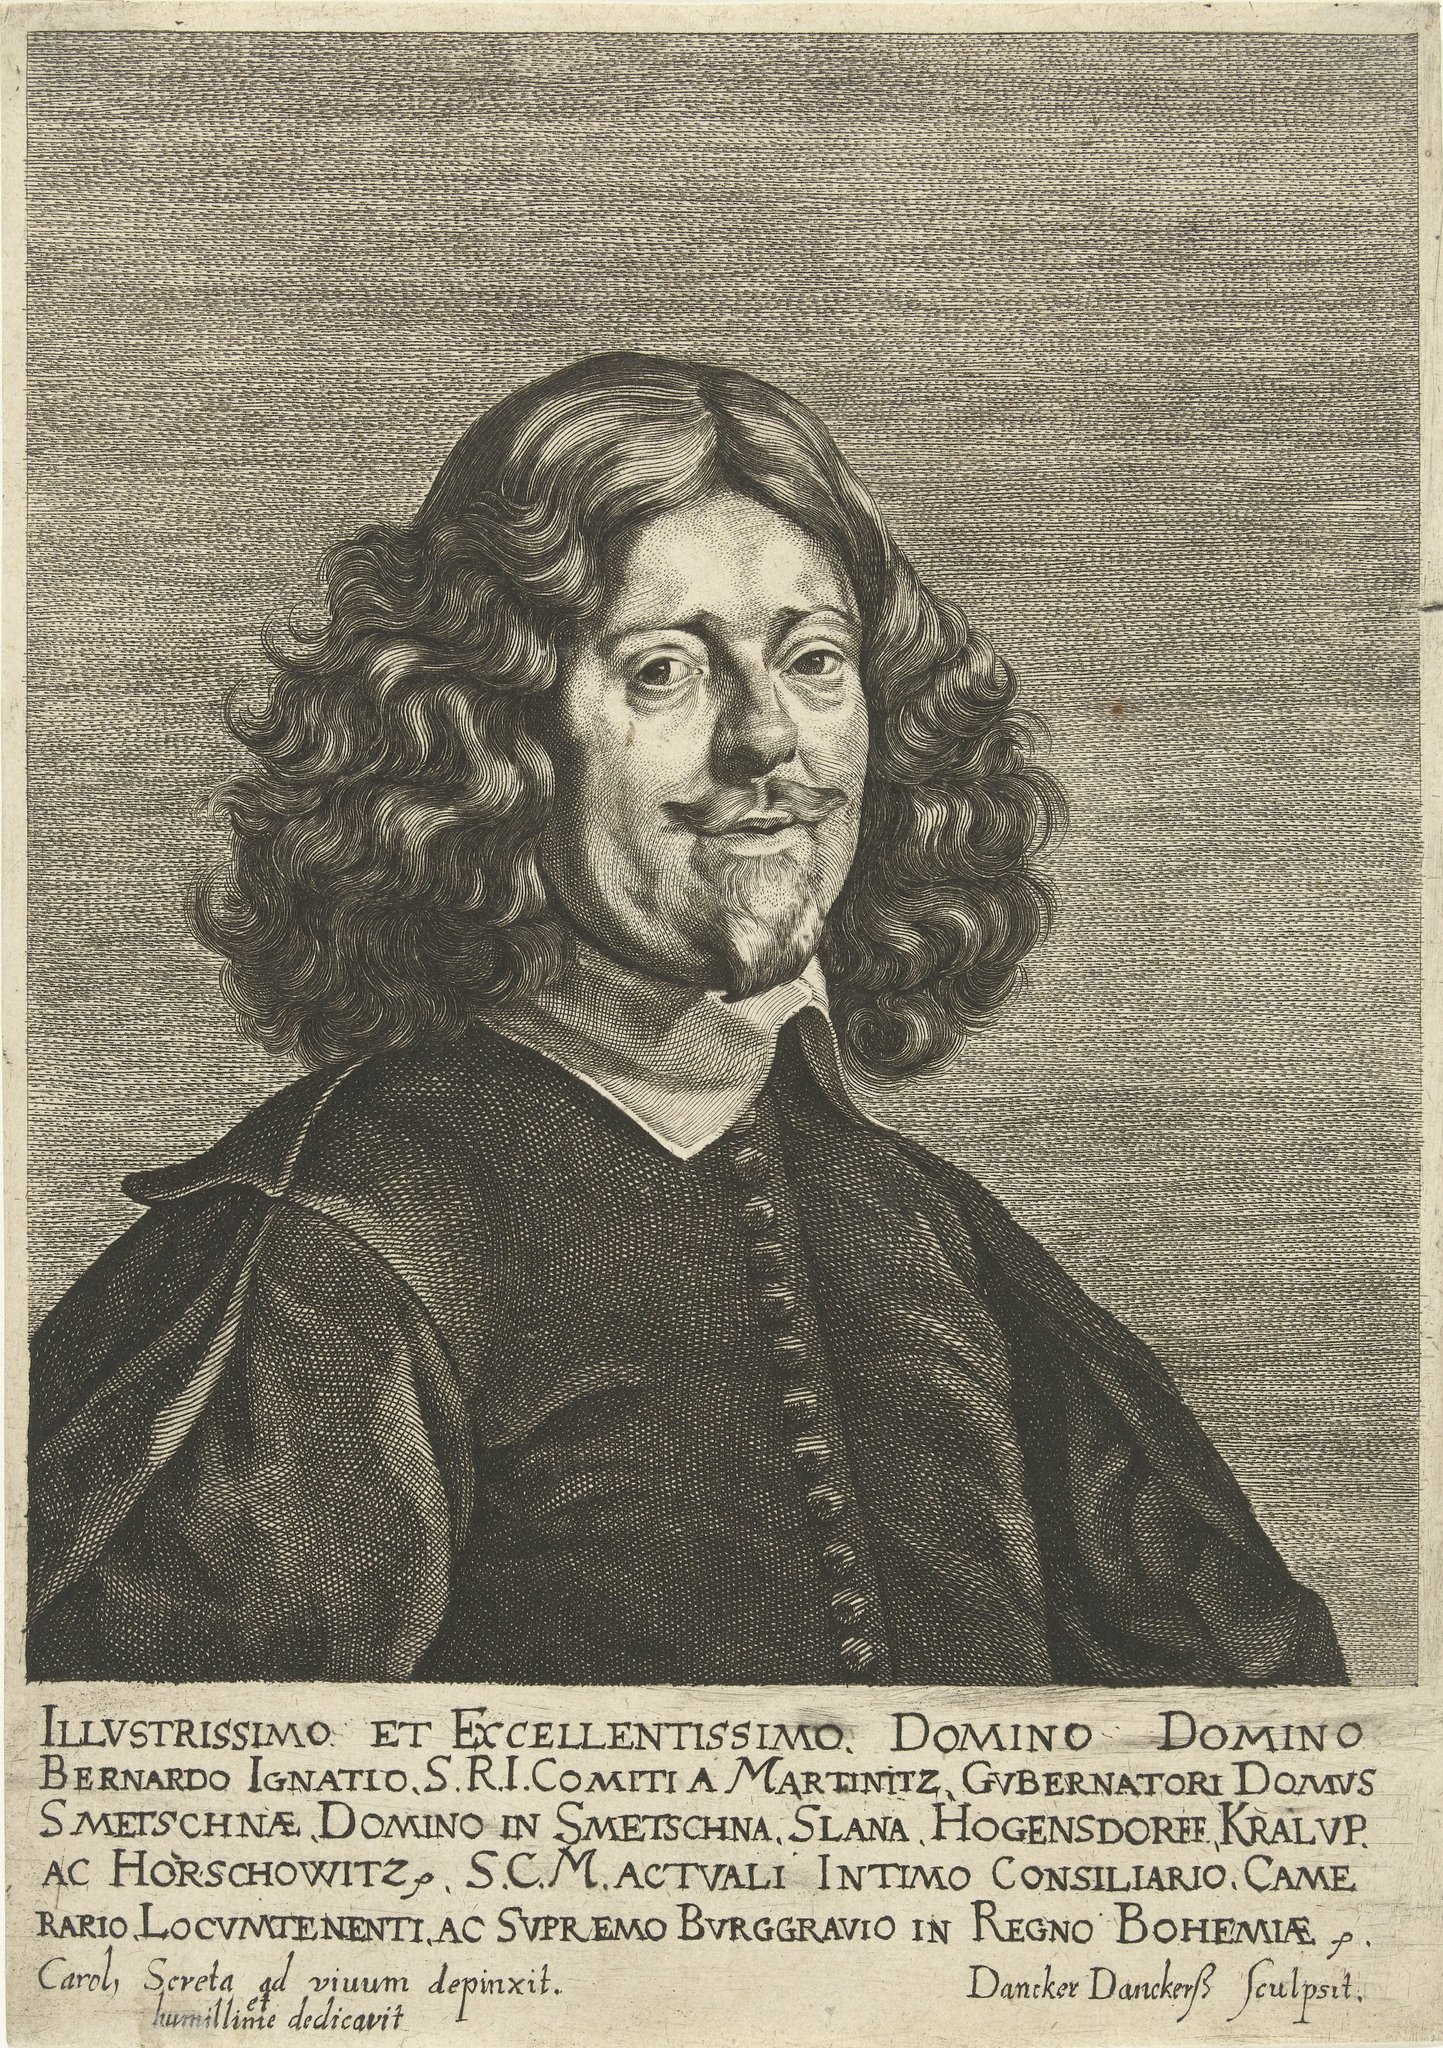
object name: print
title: Portret van Bernard Ignatius, graaf van Martinitz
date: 1643-1666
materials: paper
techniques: engraving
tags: bernardus ignatius de martinitz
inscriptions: collector's mark: Lugt 2228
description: Portret van Bernard Ignatius, graaf van Martinitz, borststuk